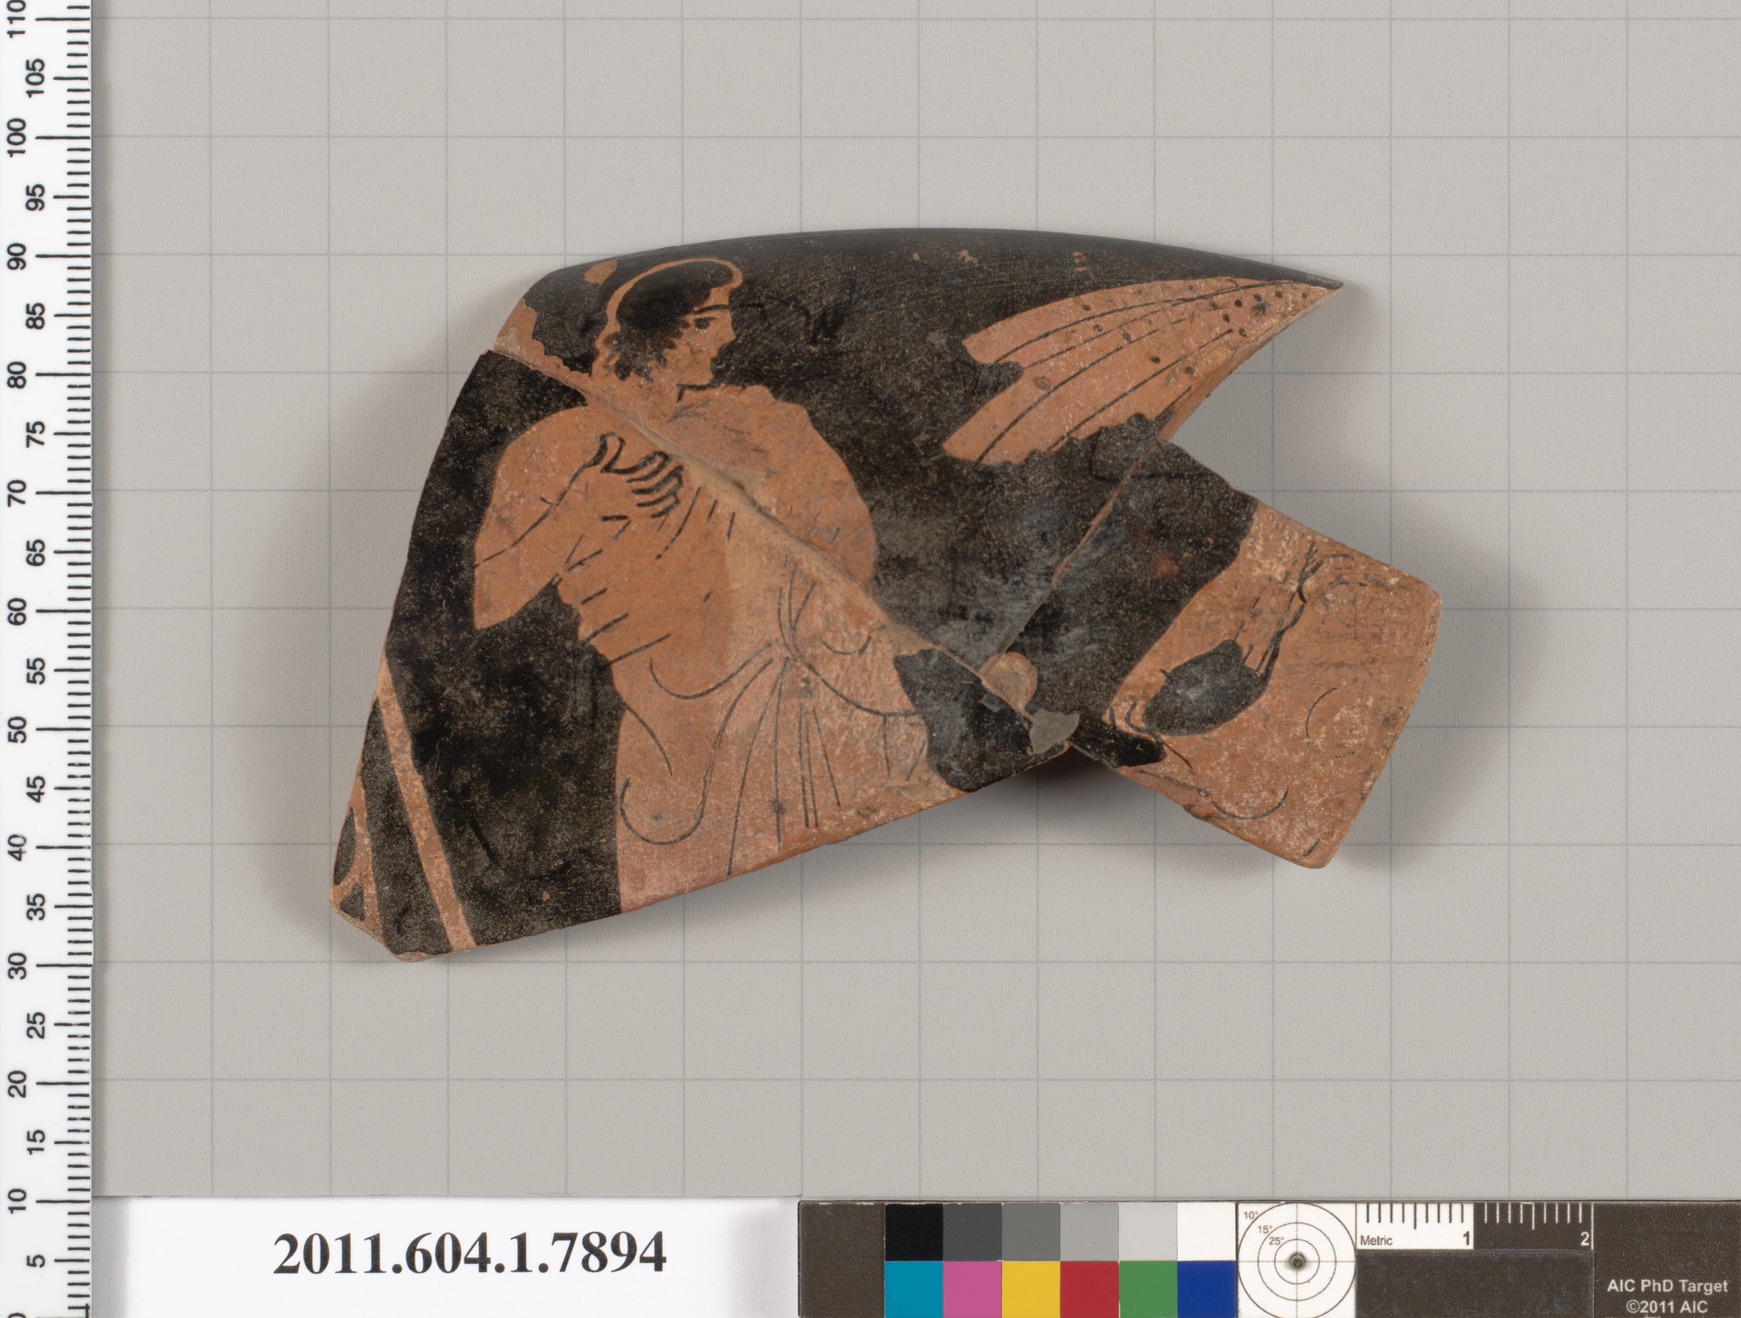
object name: kylix fragment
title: Terracotta rim fragment of a kylix (drinking cup)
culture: greek, attic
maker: painter of london e 777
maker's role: artist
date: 450 BCE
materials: terracotta